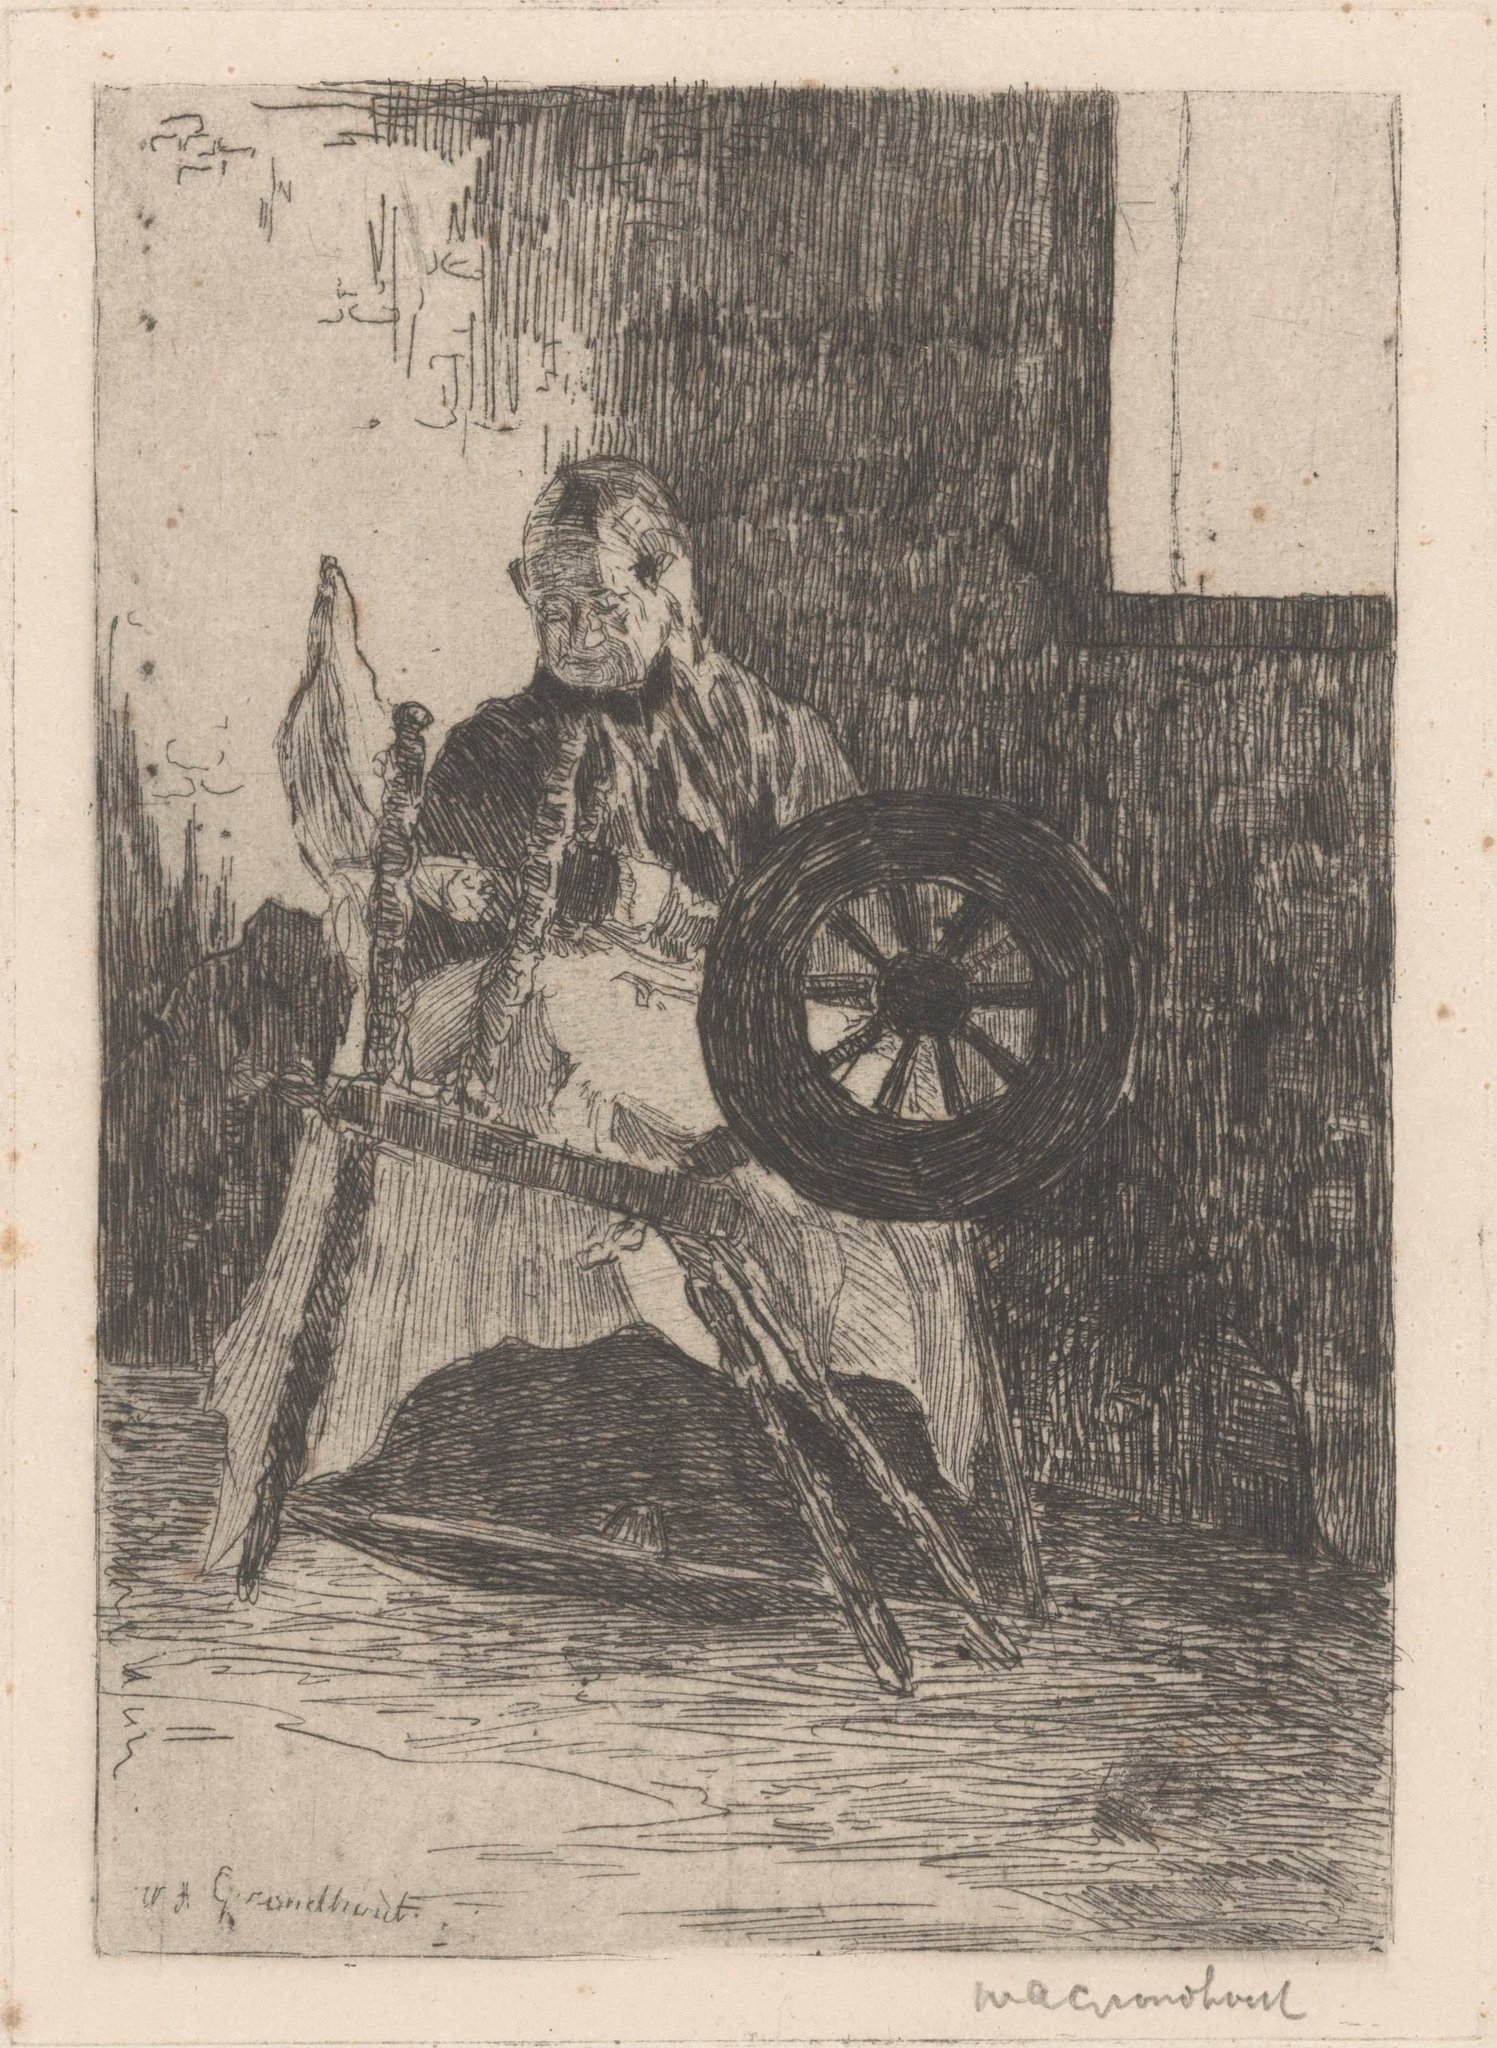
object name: print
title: Vrouw achter een spinnewiel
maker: willem adrianus grondhout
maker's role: draughtsman, painter, print maker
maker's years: 1878-1934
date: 1888-1934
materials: paper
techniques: etching, intaglio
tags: spinning-wheel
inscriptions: collector's mark: Lugt 2228